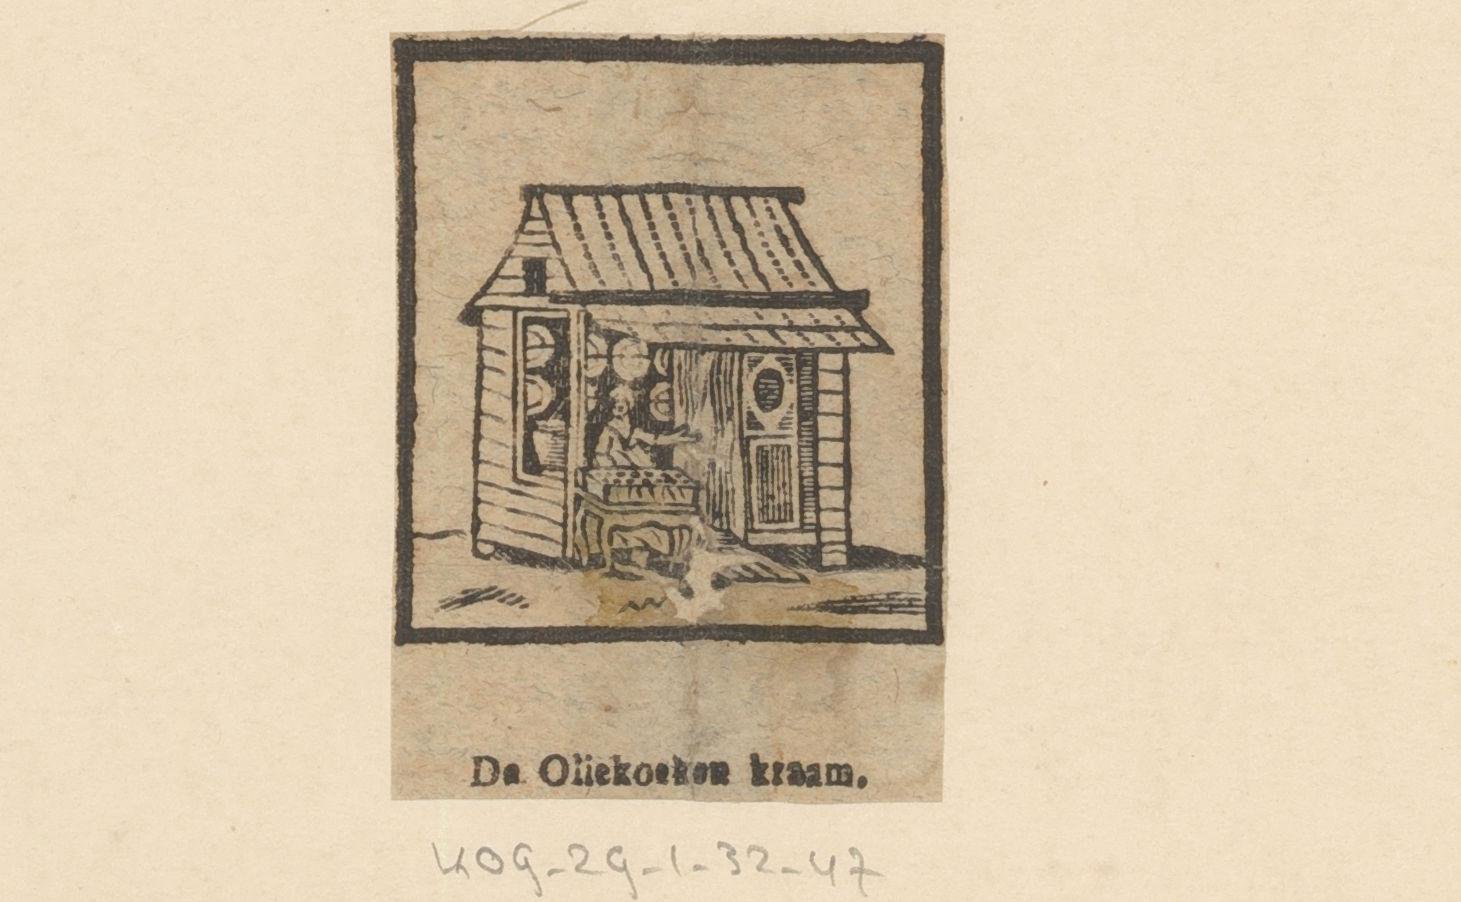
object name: print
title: De Oliekoeken kraam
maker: Anonymous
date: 1800-1899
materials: paper, watercolor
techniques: hand coloring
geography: netherlands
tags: pancakes, pleasure fair and circus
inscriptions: collector's mark: Lugt 1641, collector's mark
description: Vignet met een oliebollenkraam, op een kermis. Uit een kinderprent geknipt. Onderwerpsrubrieken binnen de Atlas Zeden en Gewoonten: Volksfeesten; Kermis.